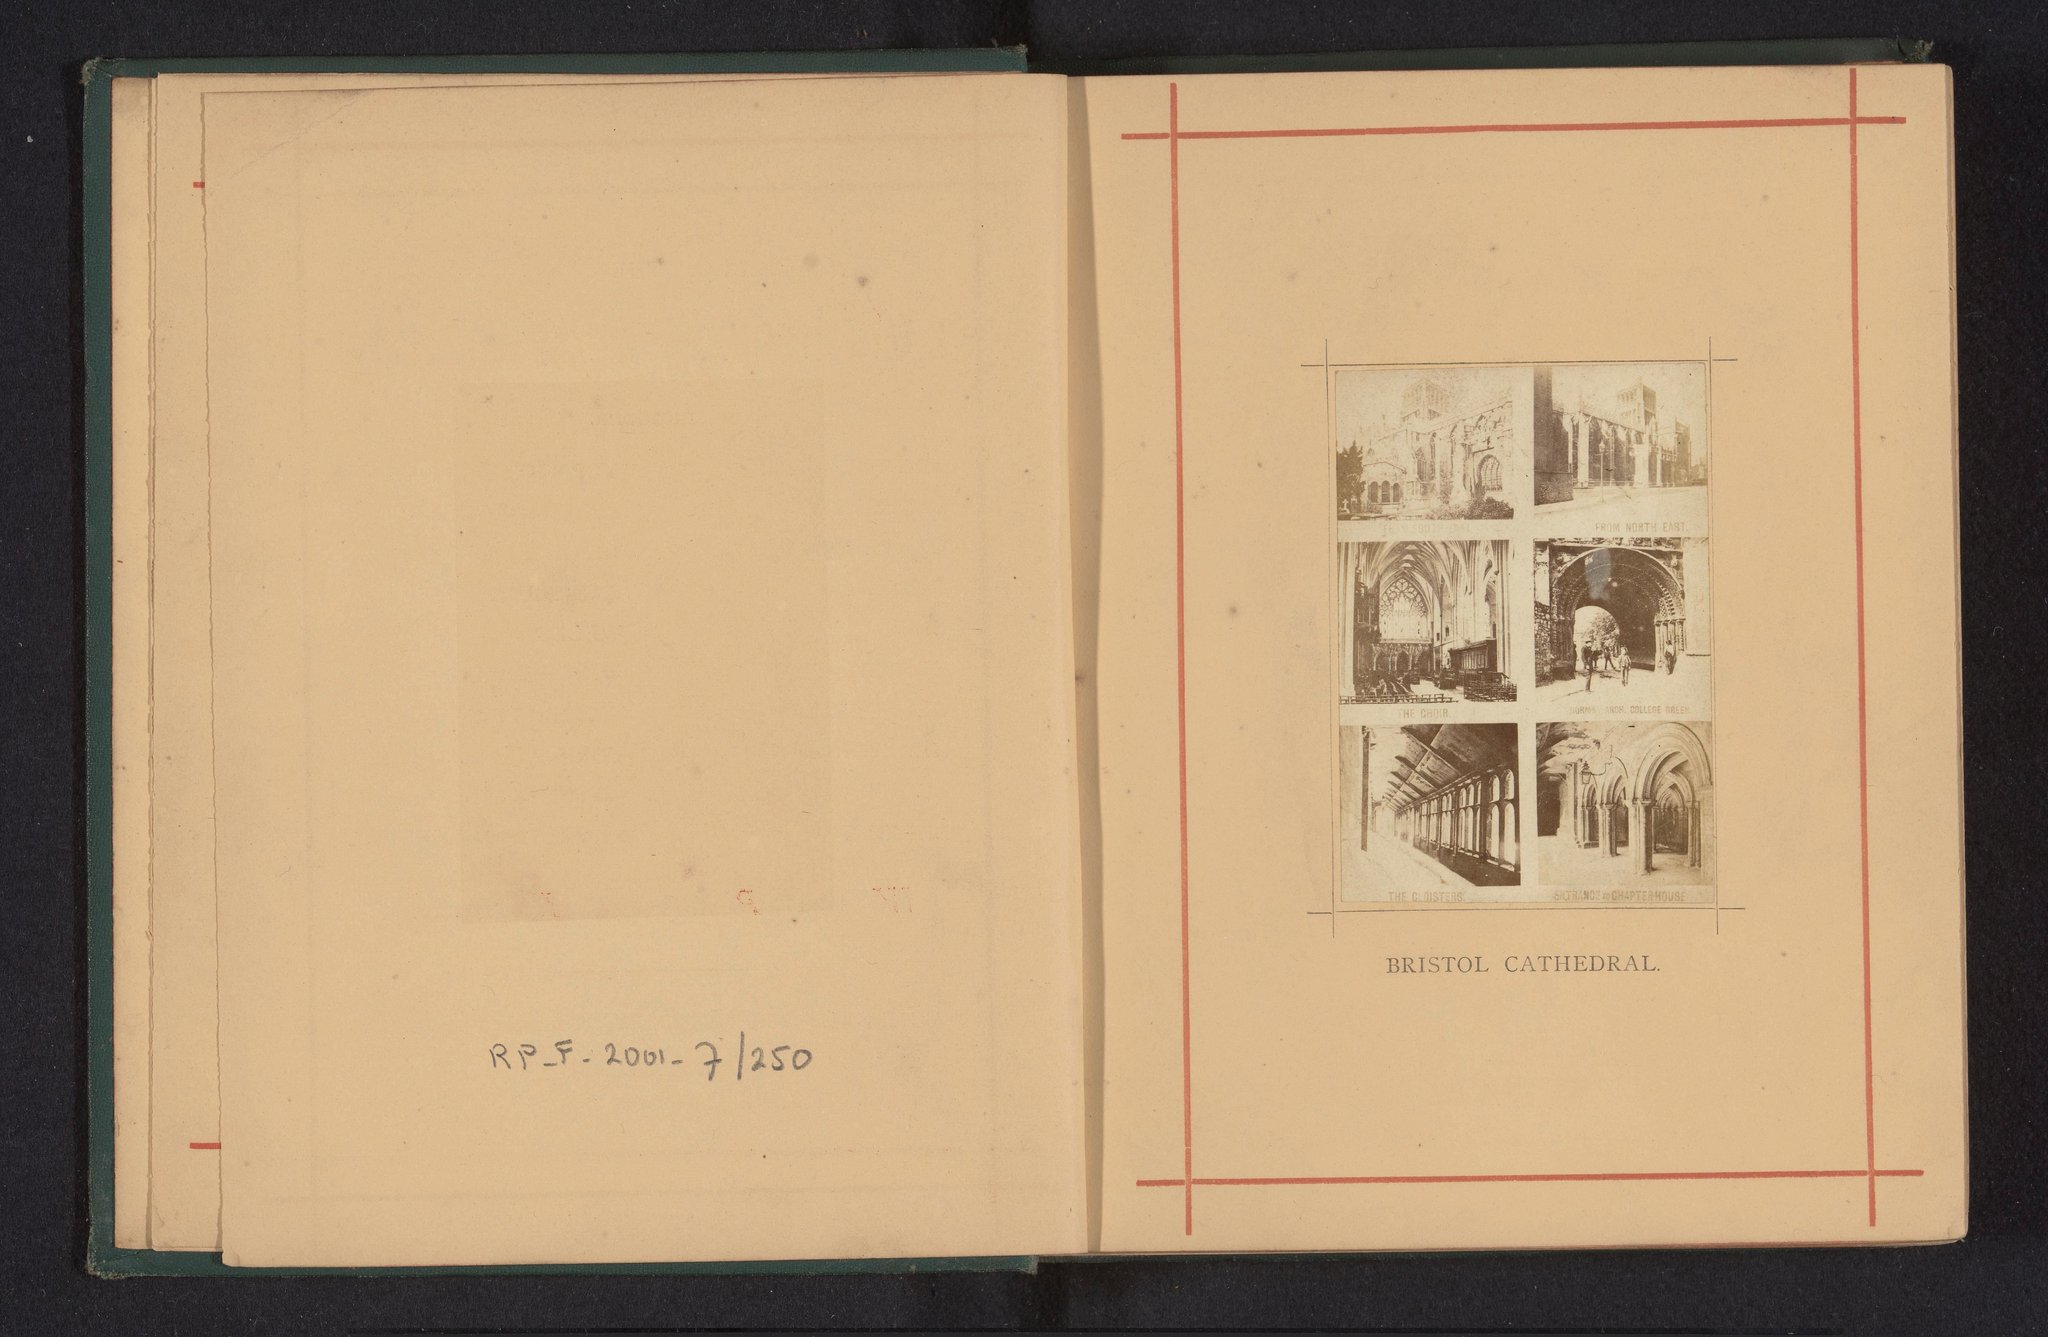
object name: page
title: Fotoreproductie van zes foto's van de kathedraal van Bristol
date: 1870-1880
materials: photographic support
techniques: albumen print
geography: bristol cathedral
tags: church (exterior), cloisters ~ monastery, parts of church interior: choir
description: Vanaf linksboven, met de klok mee: tweemaal de façade, een poort, ingang van de kapittelzaal, zuilengalerij en het koor.